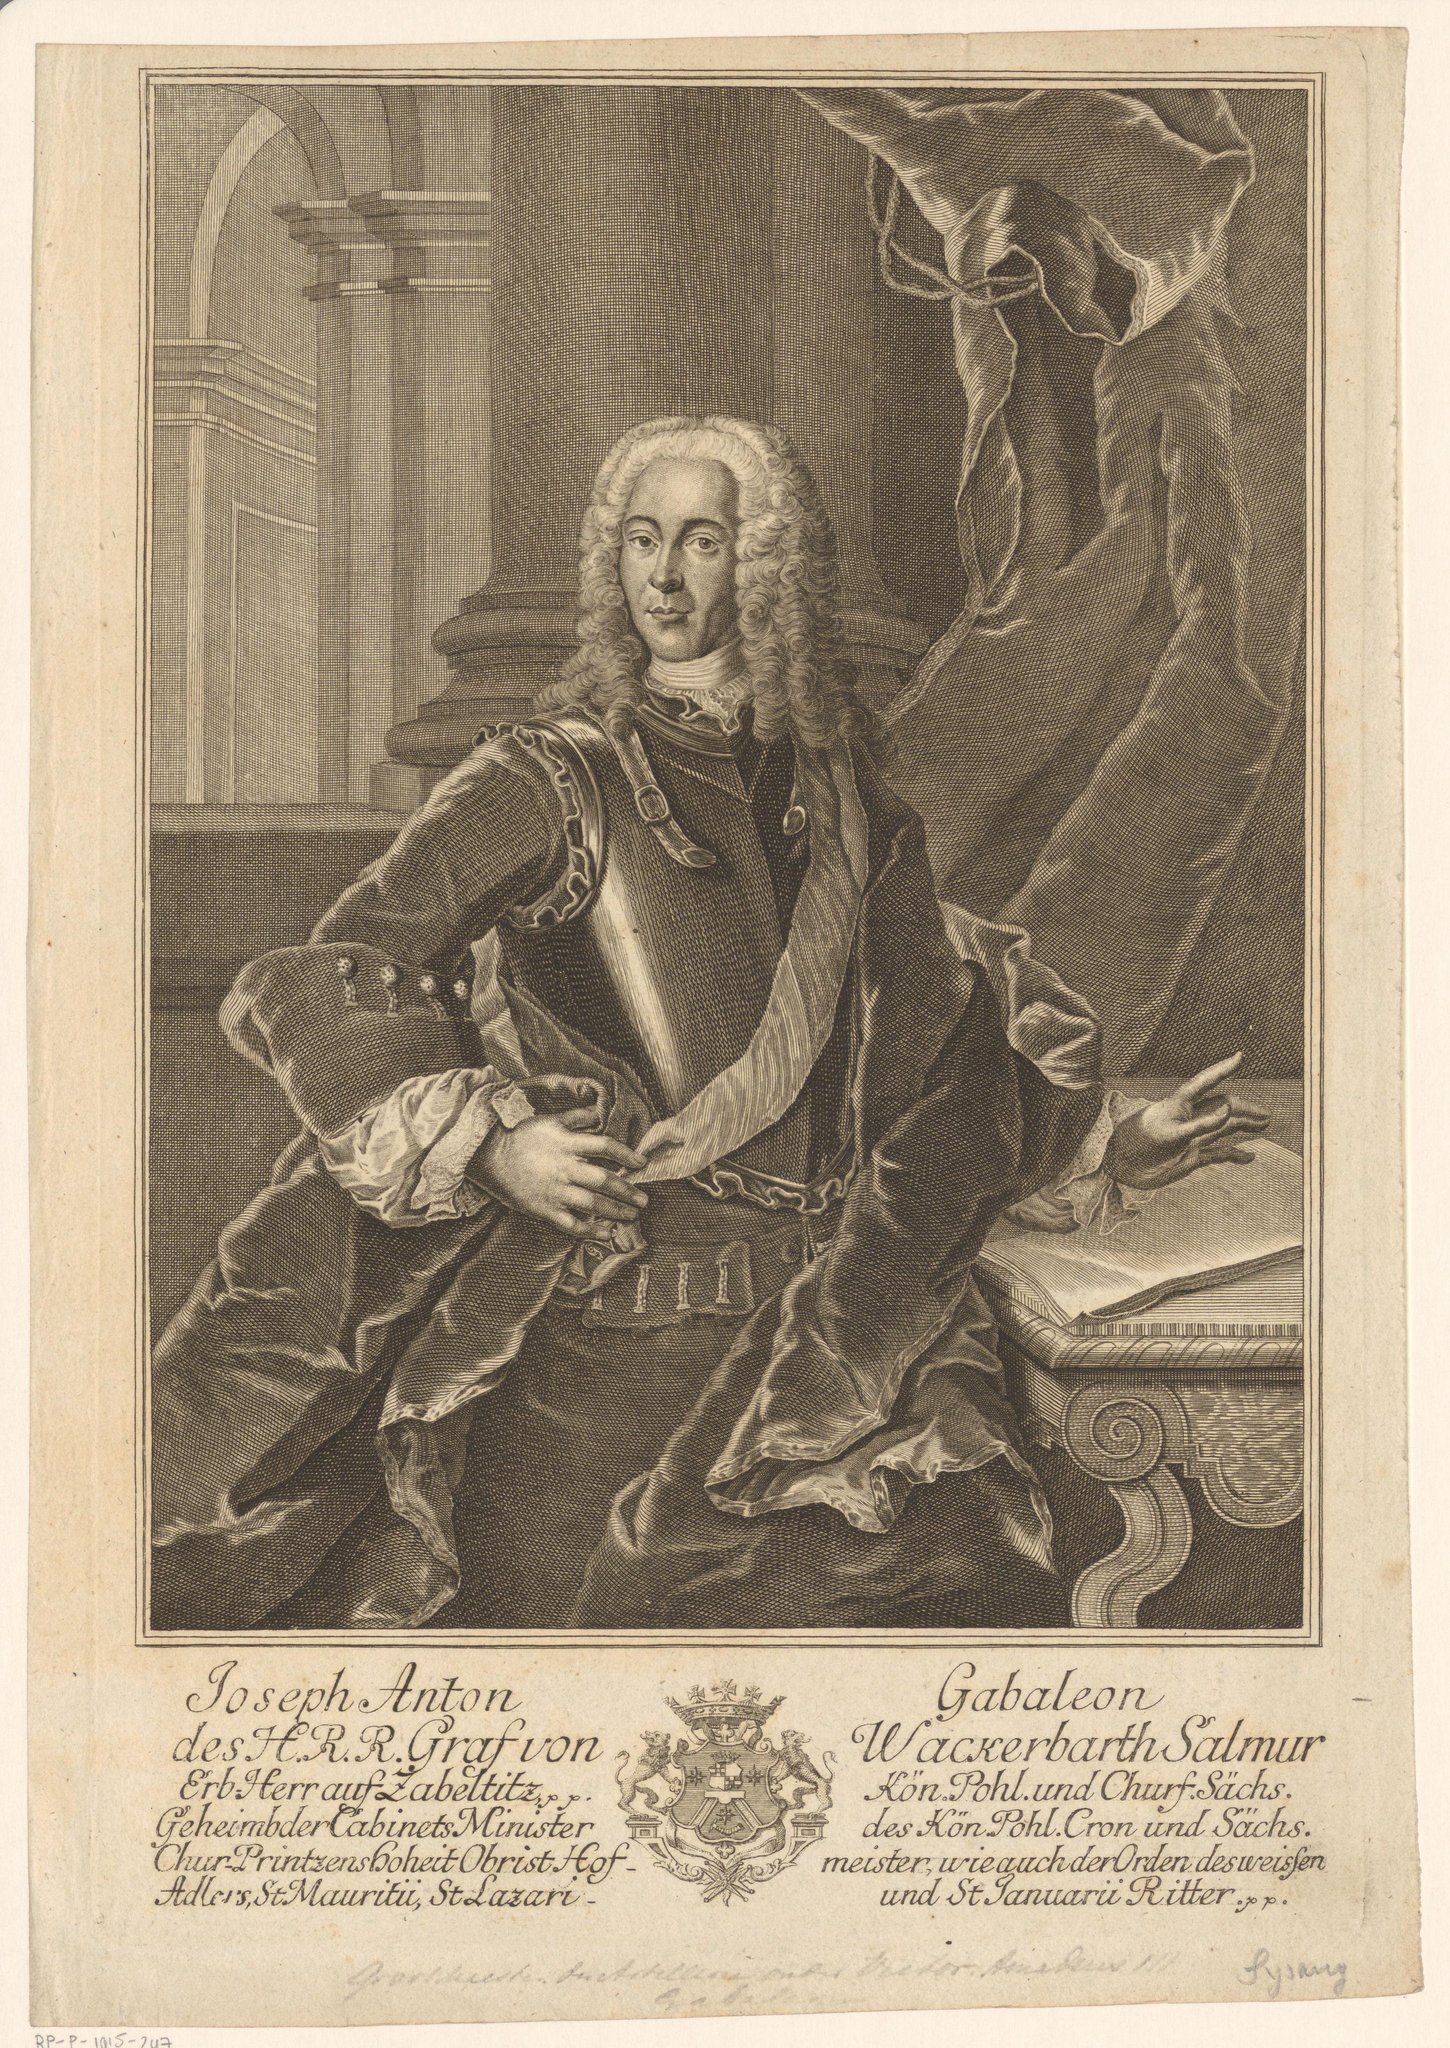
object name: print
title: Portret van Joseph Anton Gabaleon, Graf von Wackerbarth-Salmour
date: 1720-1757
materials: paper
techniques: engraving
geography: leipzig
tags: armour, historical persons, armorial bearing, heraldry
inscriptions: collector's mark: Lugt 2228